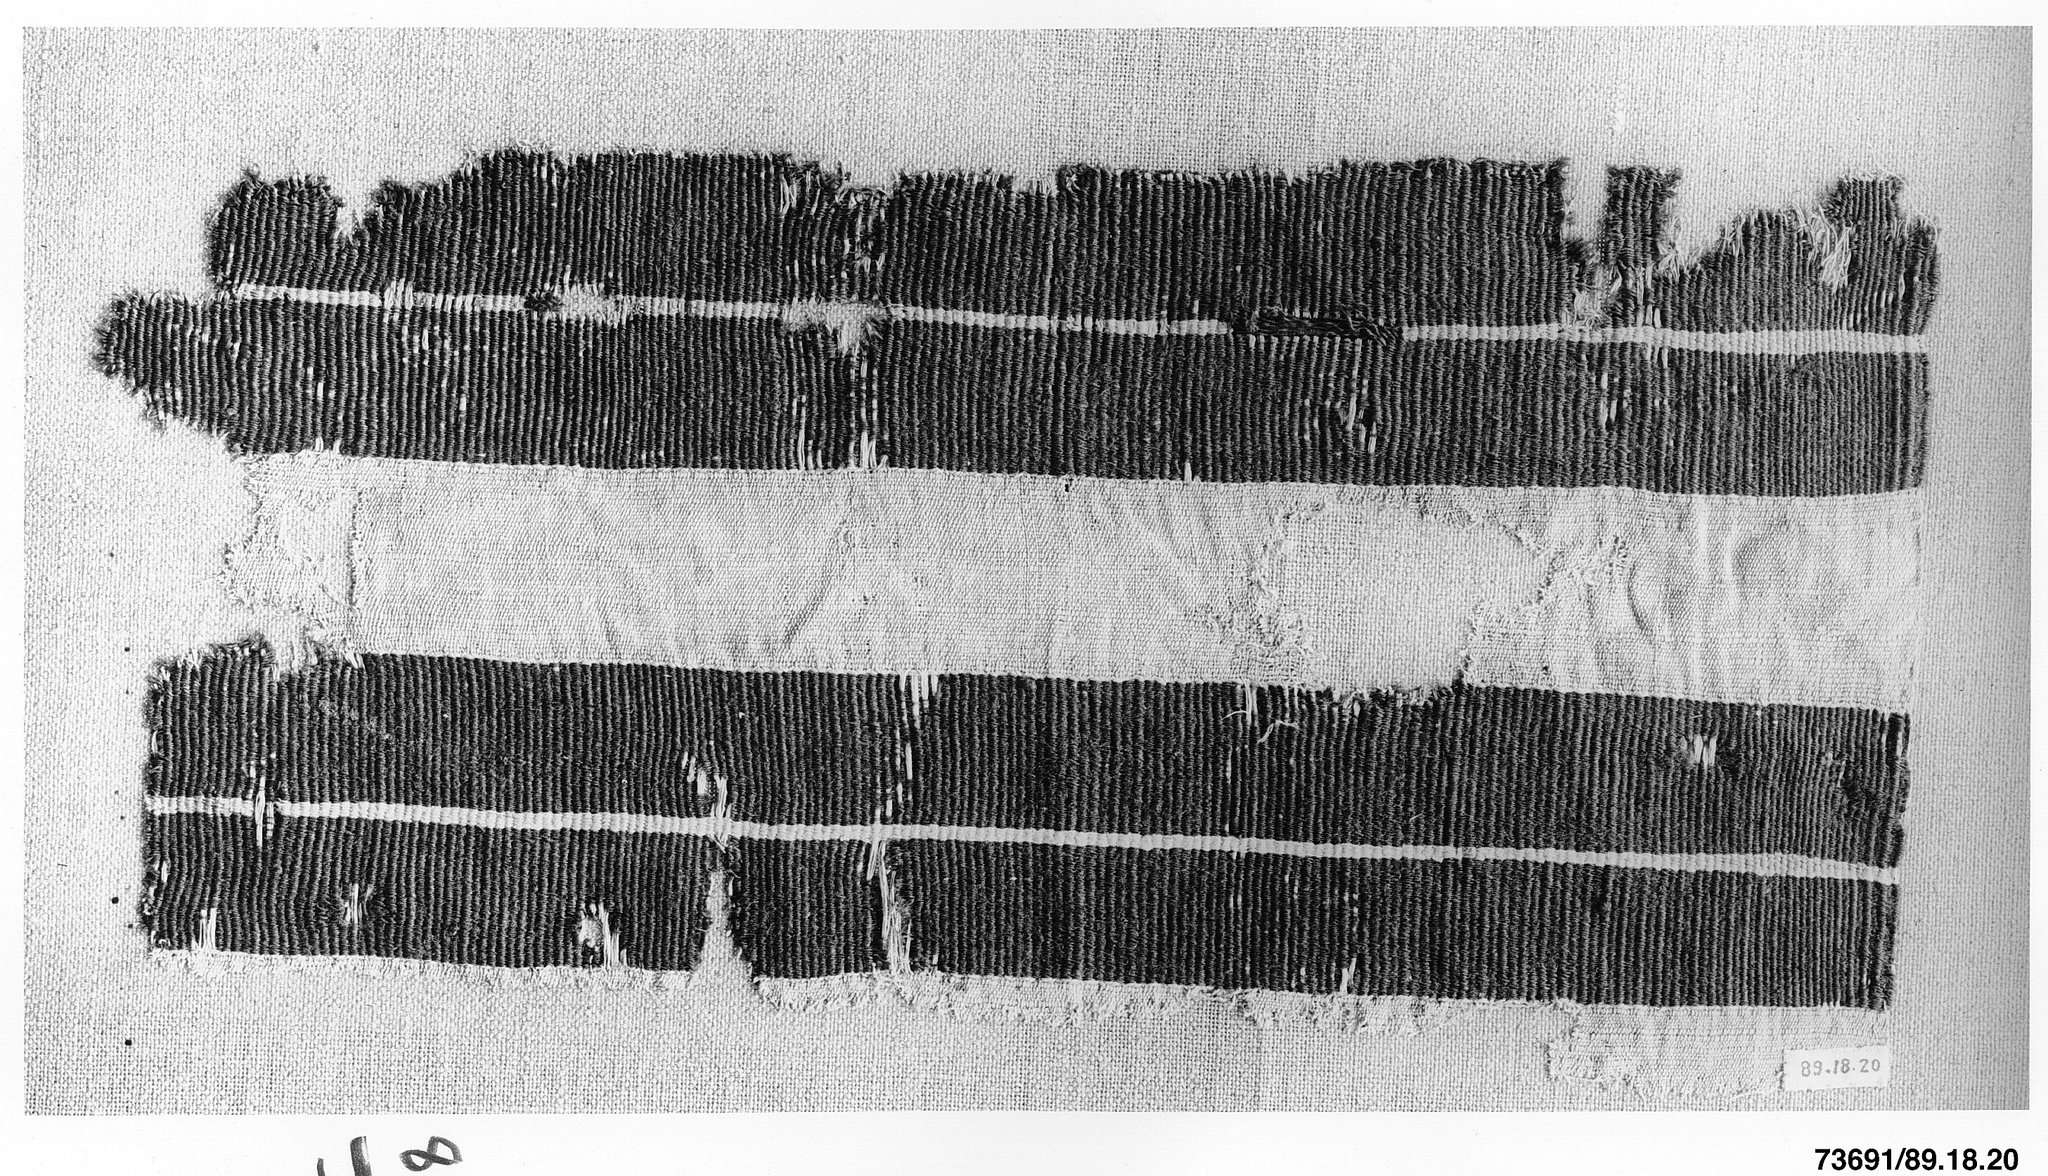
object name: textile fragment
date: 201-400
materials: linen, wool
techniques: weave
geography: egypt